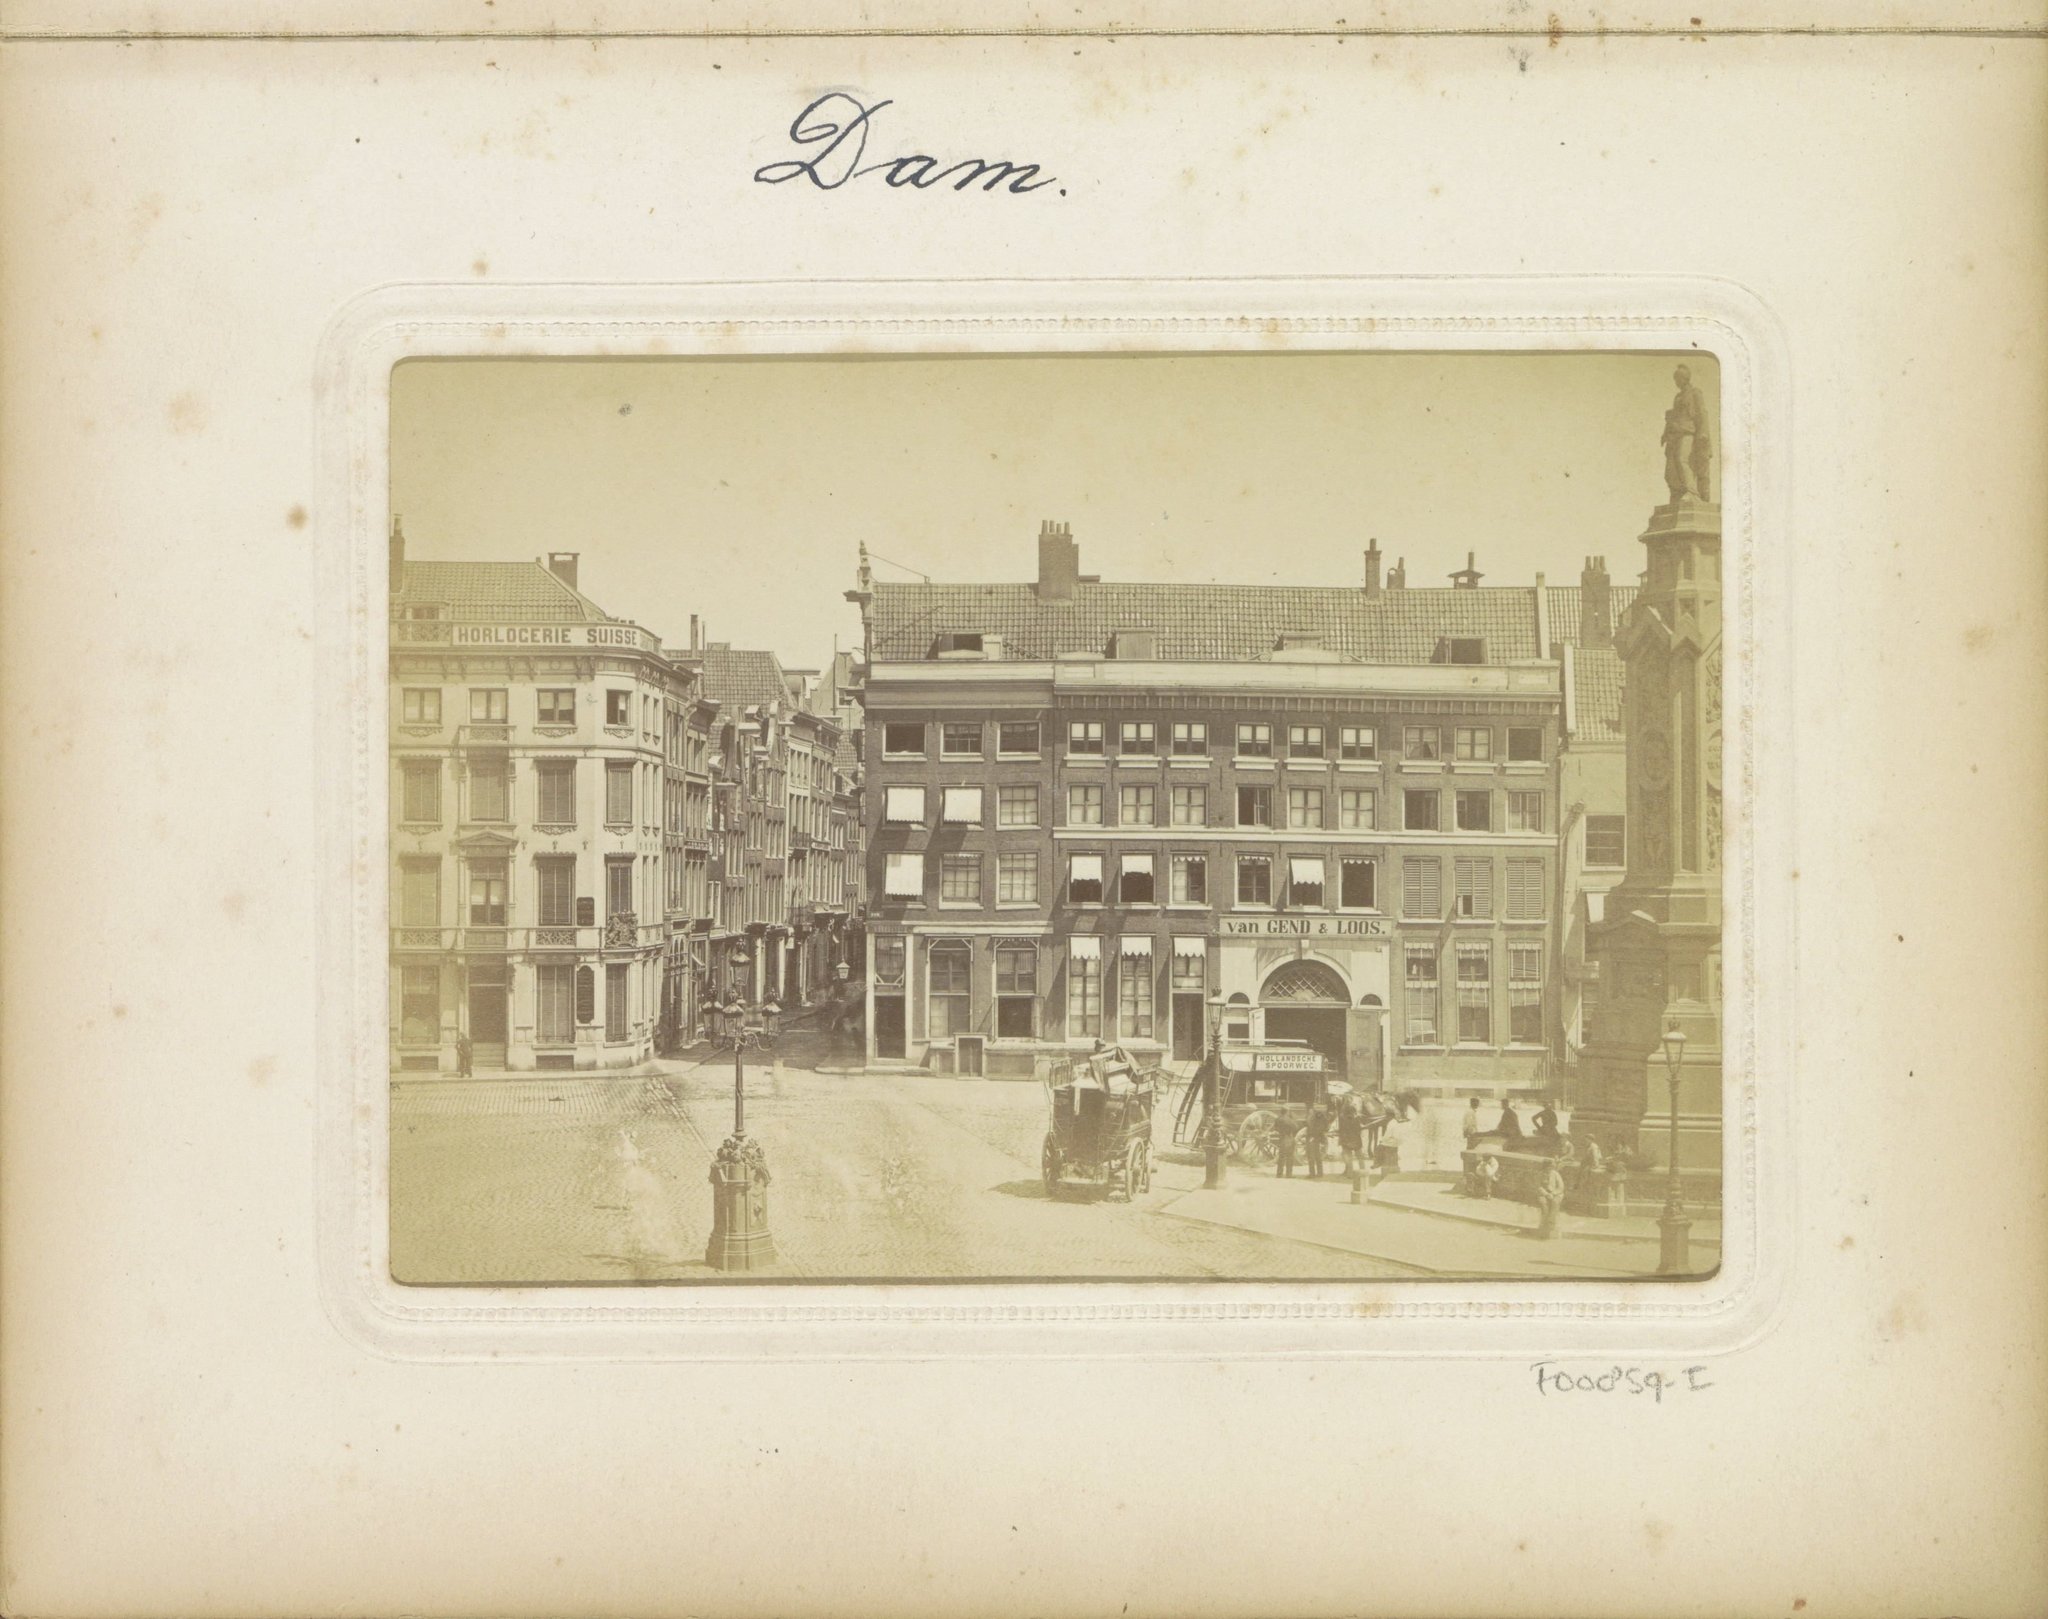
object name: photograph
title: Gezicht op de noordzijde van de Dam met omnibussen van de Hollandsche Spoorweg, het gebouw van Van Gend & Loos en links de ingang van de Nieuwendijk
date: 1850-1875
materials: cardboard, paper, photographic support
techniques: albumen print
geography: amsterdam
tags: animal traction, animal-drawn vehicle (carriage etc.), square, place, circus, etc. (+ city(-scape) with figures, staffage), prospect of city, town panorama, silhouette of city, amsterdam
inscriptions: inscription: ‘Rooswinkel & Co. Dam Amsterdam.’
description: Onderdeel van Fotoalbum met opnames van straten, pleinen en grachten in Amsterdam.